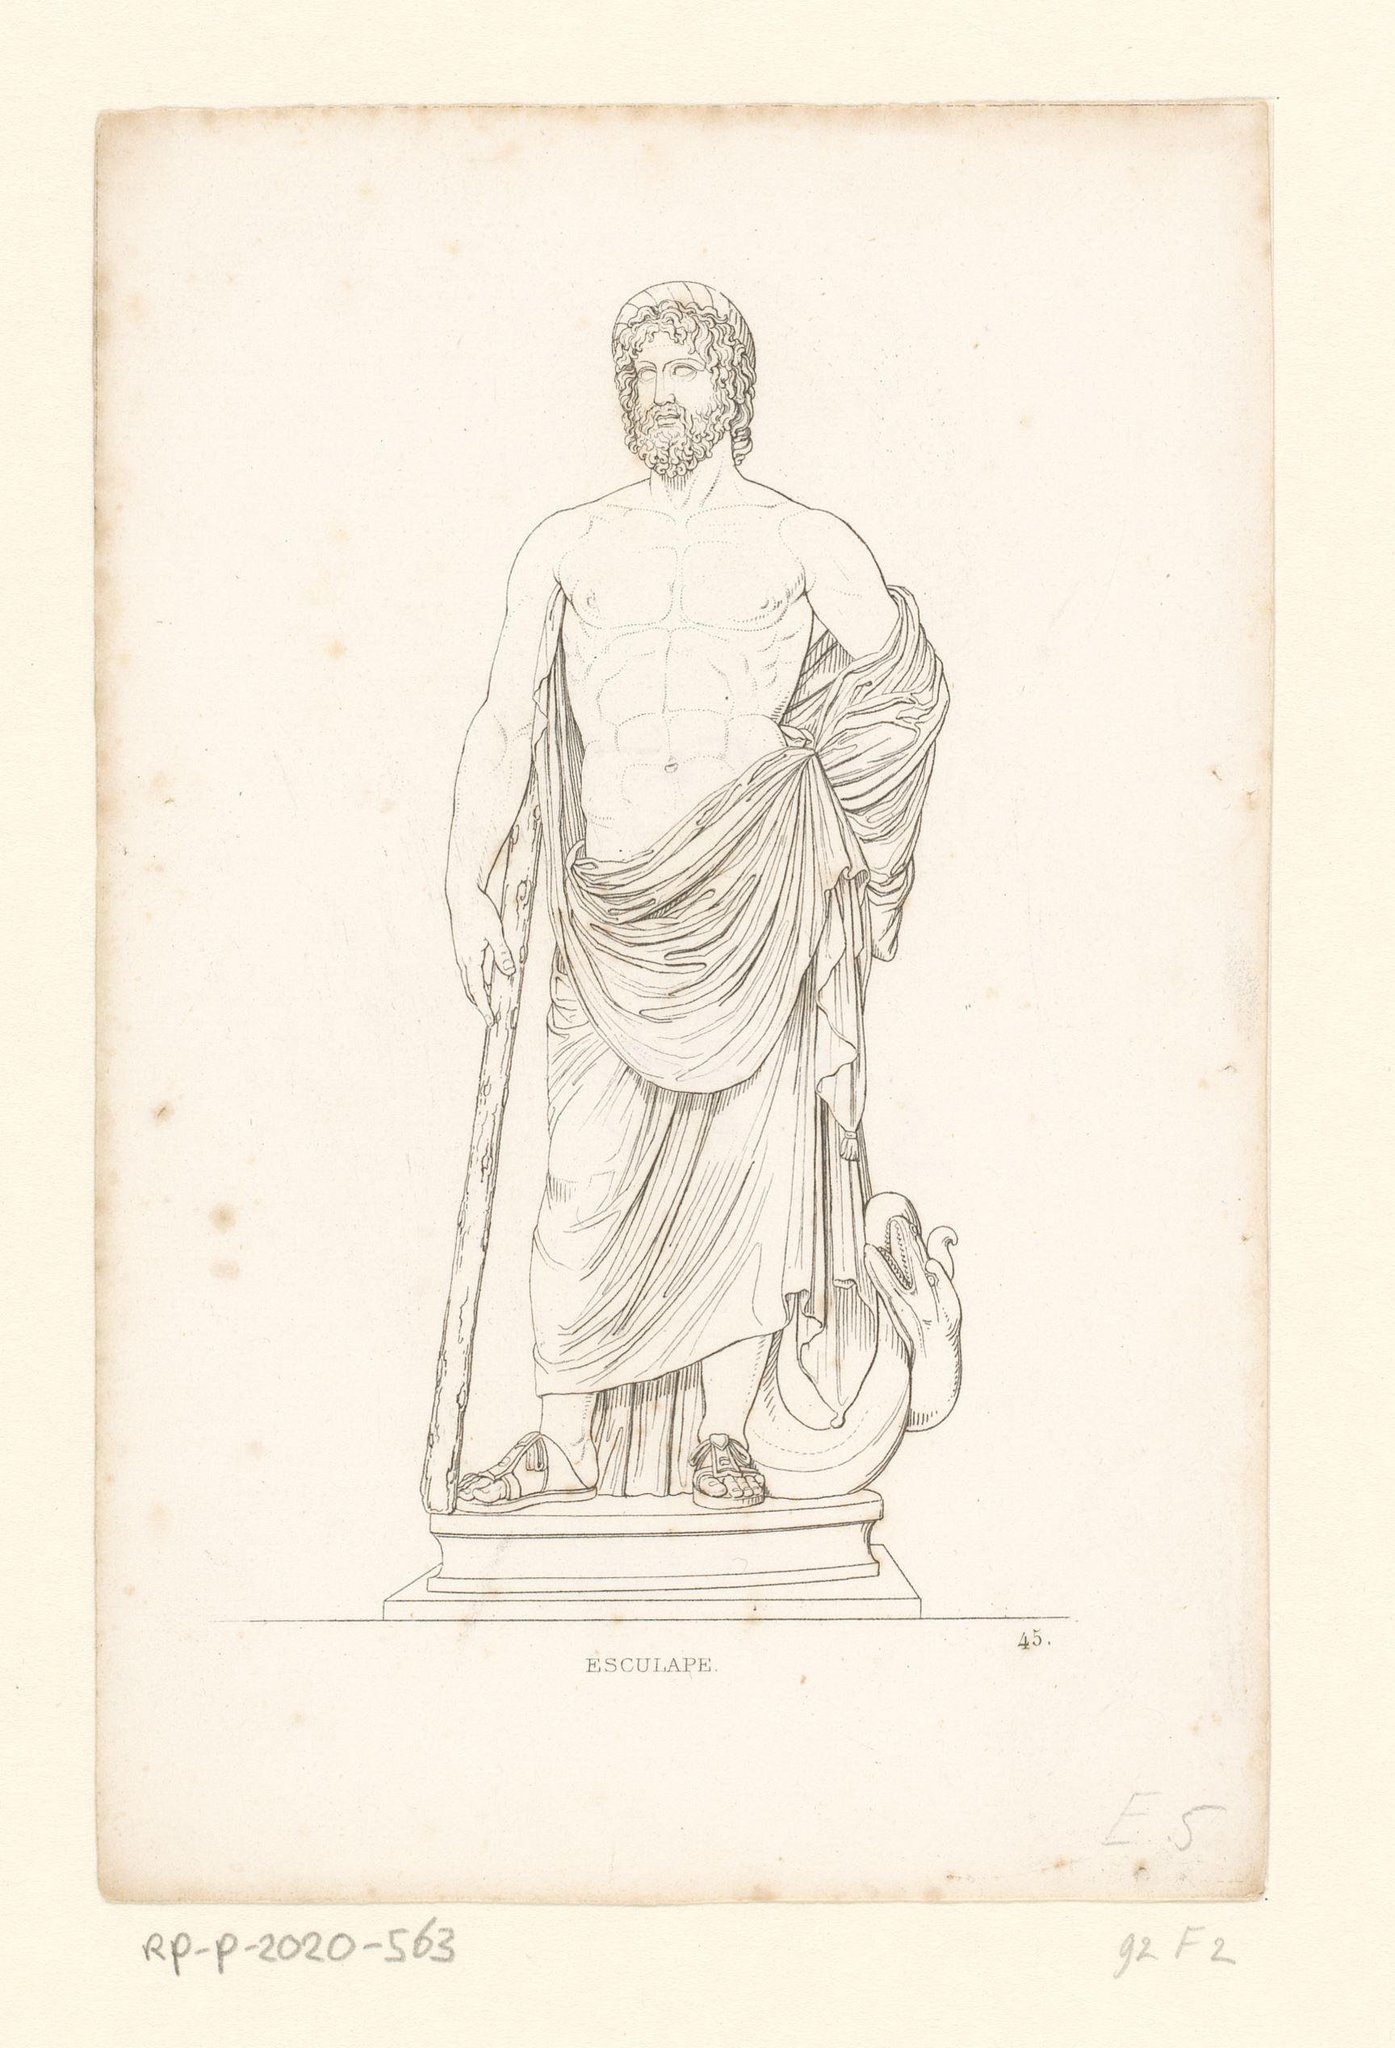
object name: book illustration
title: Asklepios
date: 1830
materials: paper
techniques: etching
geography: paris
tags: (story of) aesculapius (asclepius)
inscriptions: collector's mark: Lugt 2228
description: Prent ook gebruikt in: Duchesne, Jean. Musée de peinture et de sculpture, ou Recueil des principaux tableaux, statues et bas-reliefs (...). Parijs: Louis-Eustache Audot, 1830, dl. 7.